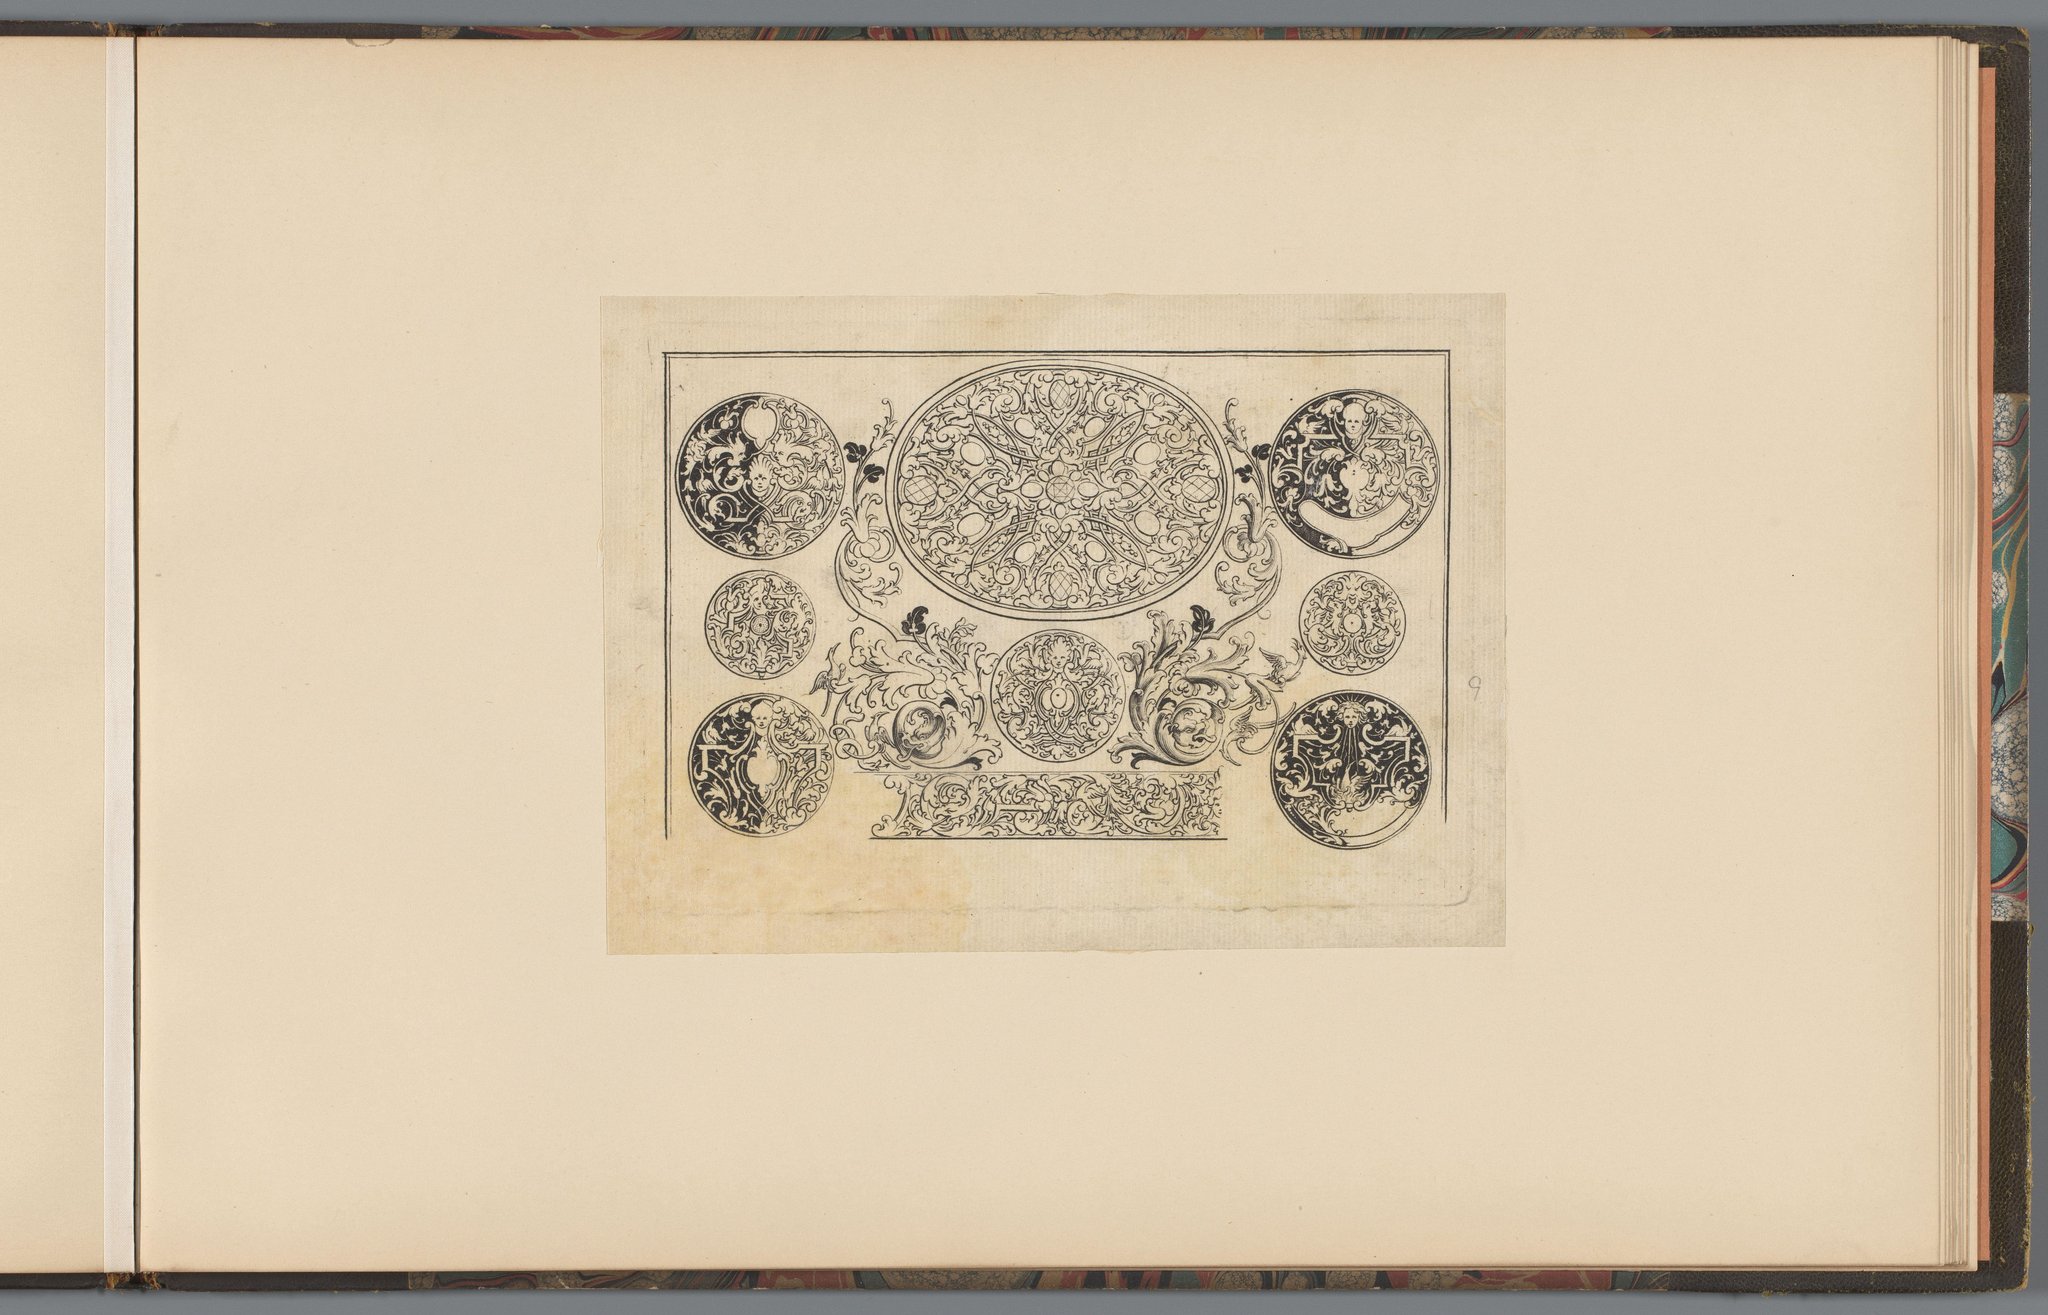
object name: album leaf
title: Zeven ontwerpen voor horlogekasten en een deksel van een snuifdoos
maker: johann lorenz hönnig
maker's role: print maker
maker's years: 1674-1713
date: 1707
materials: paper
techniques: engraving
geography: nuremberg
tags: ornaments ~ art, snuff-box, watch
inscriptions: number: ‘9’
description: Zwartornamenten. Prent maakt deel uit van een album.